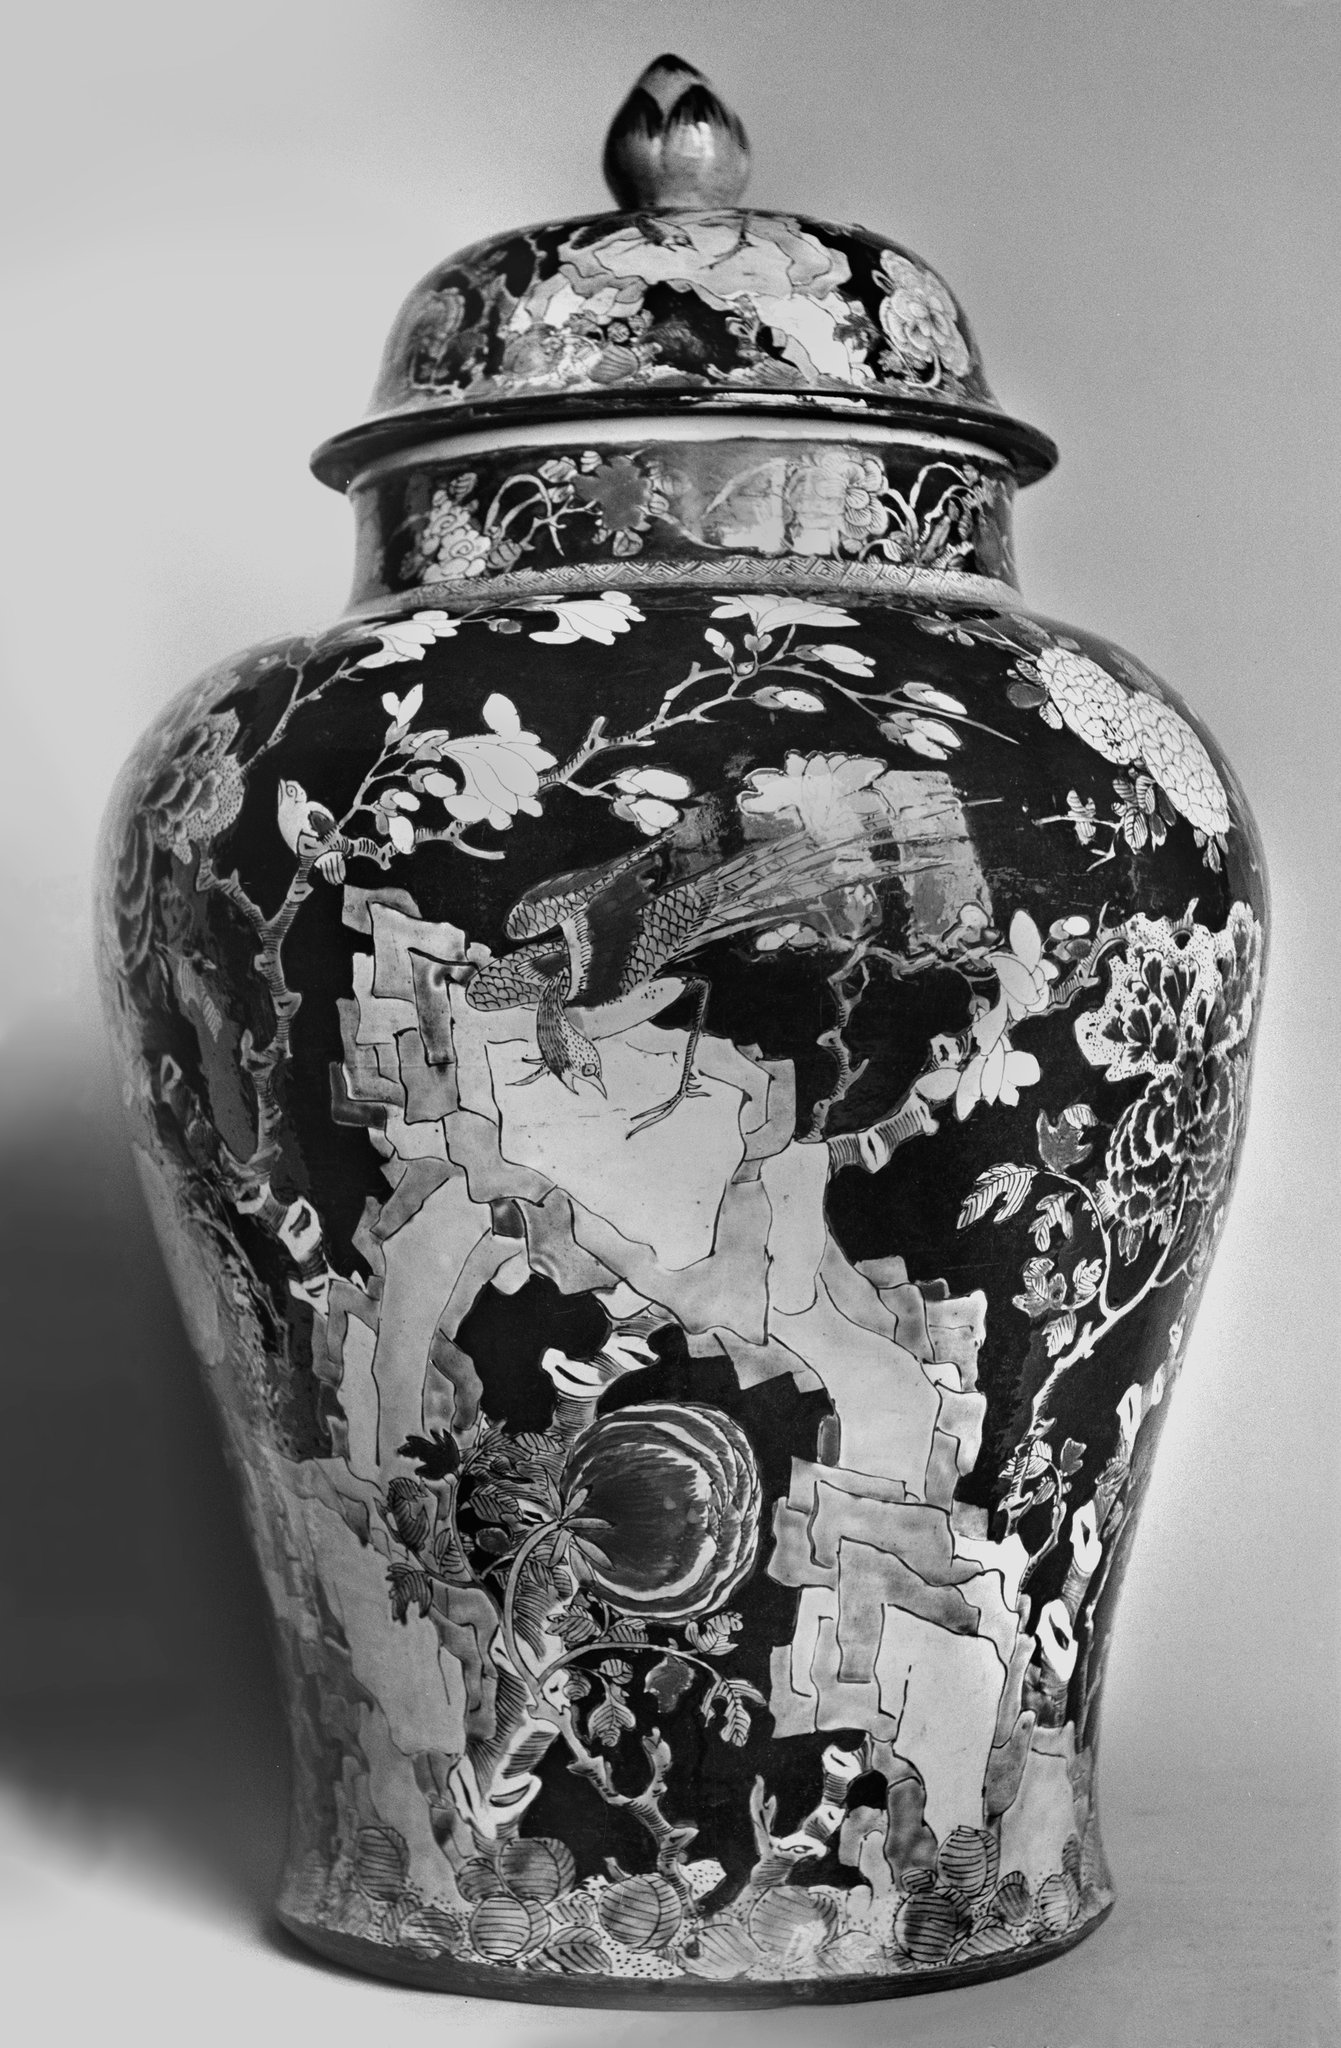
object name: covered jar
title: Covered jar with birds and flowers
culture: chinese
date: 1801-1900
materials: enamel, porcelain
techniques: painting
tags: birds,flowers